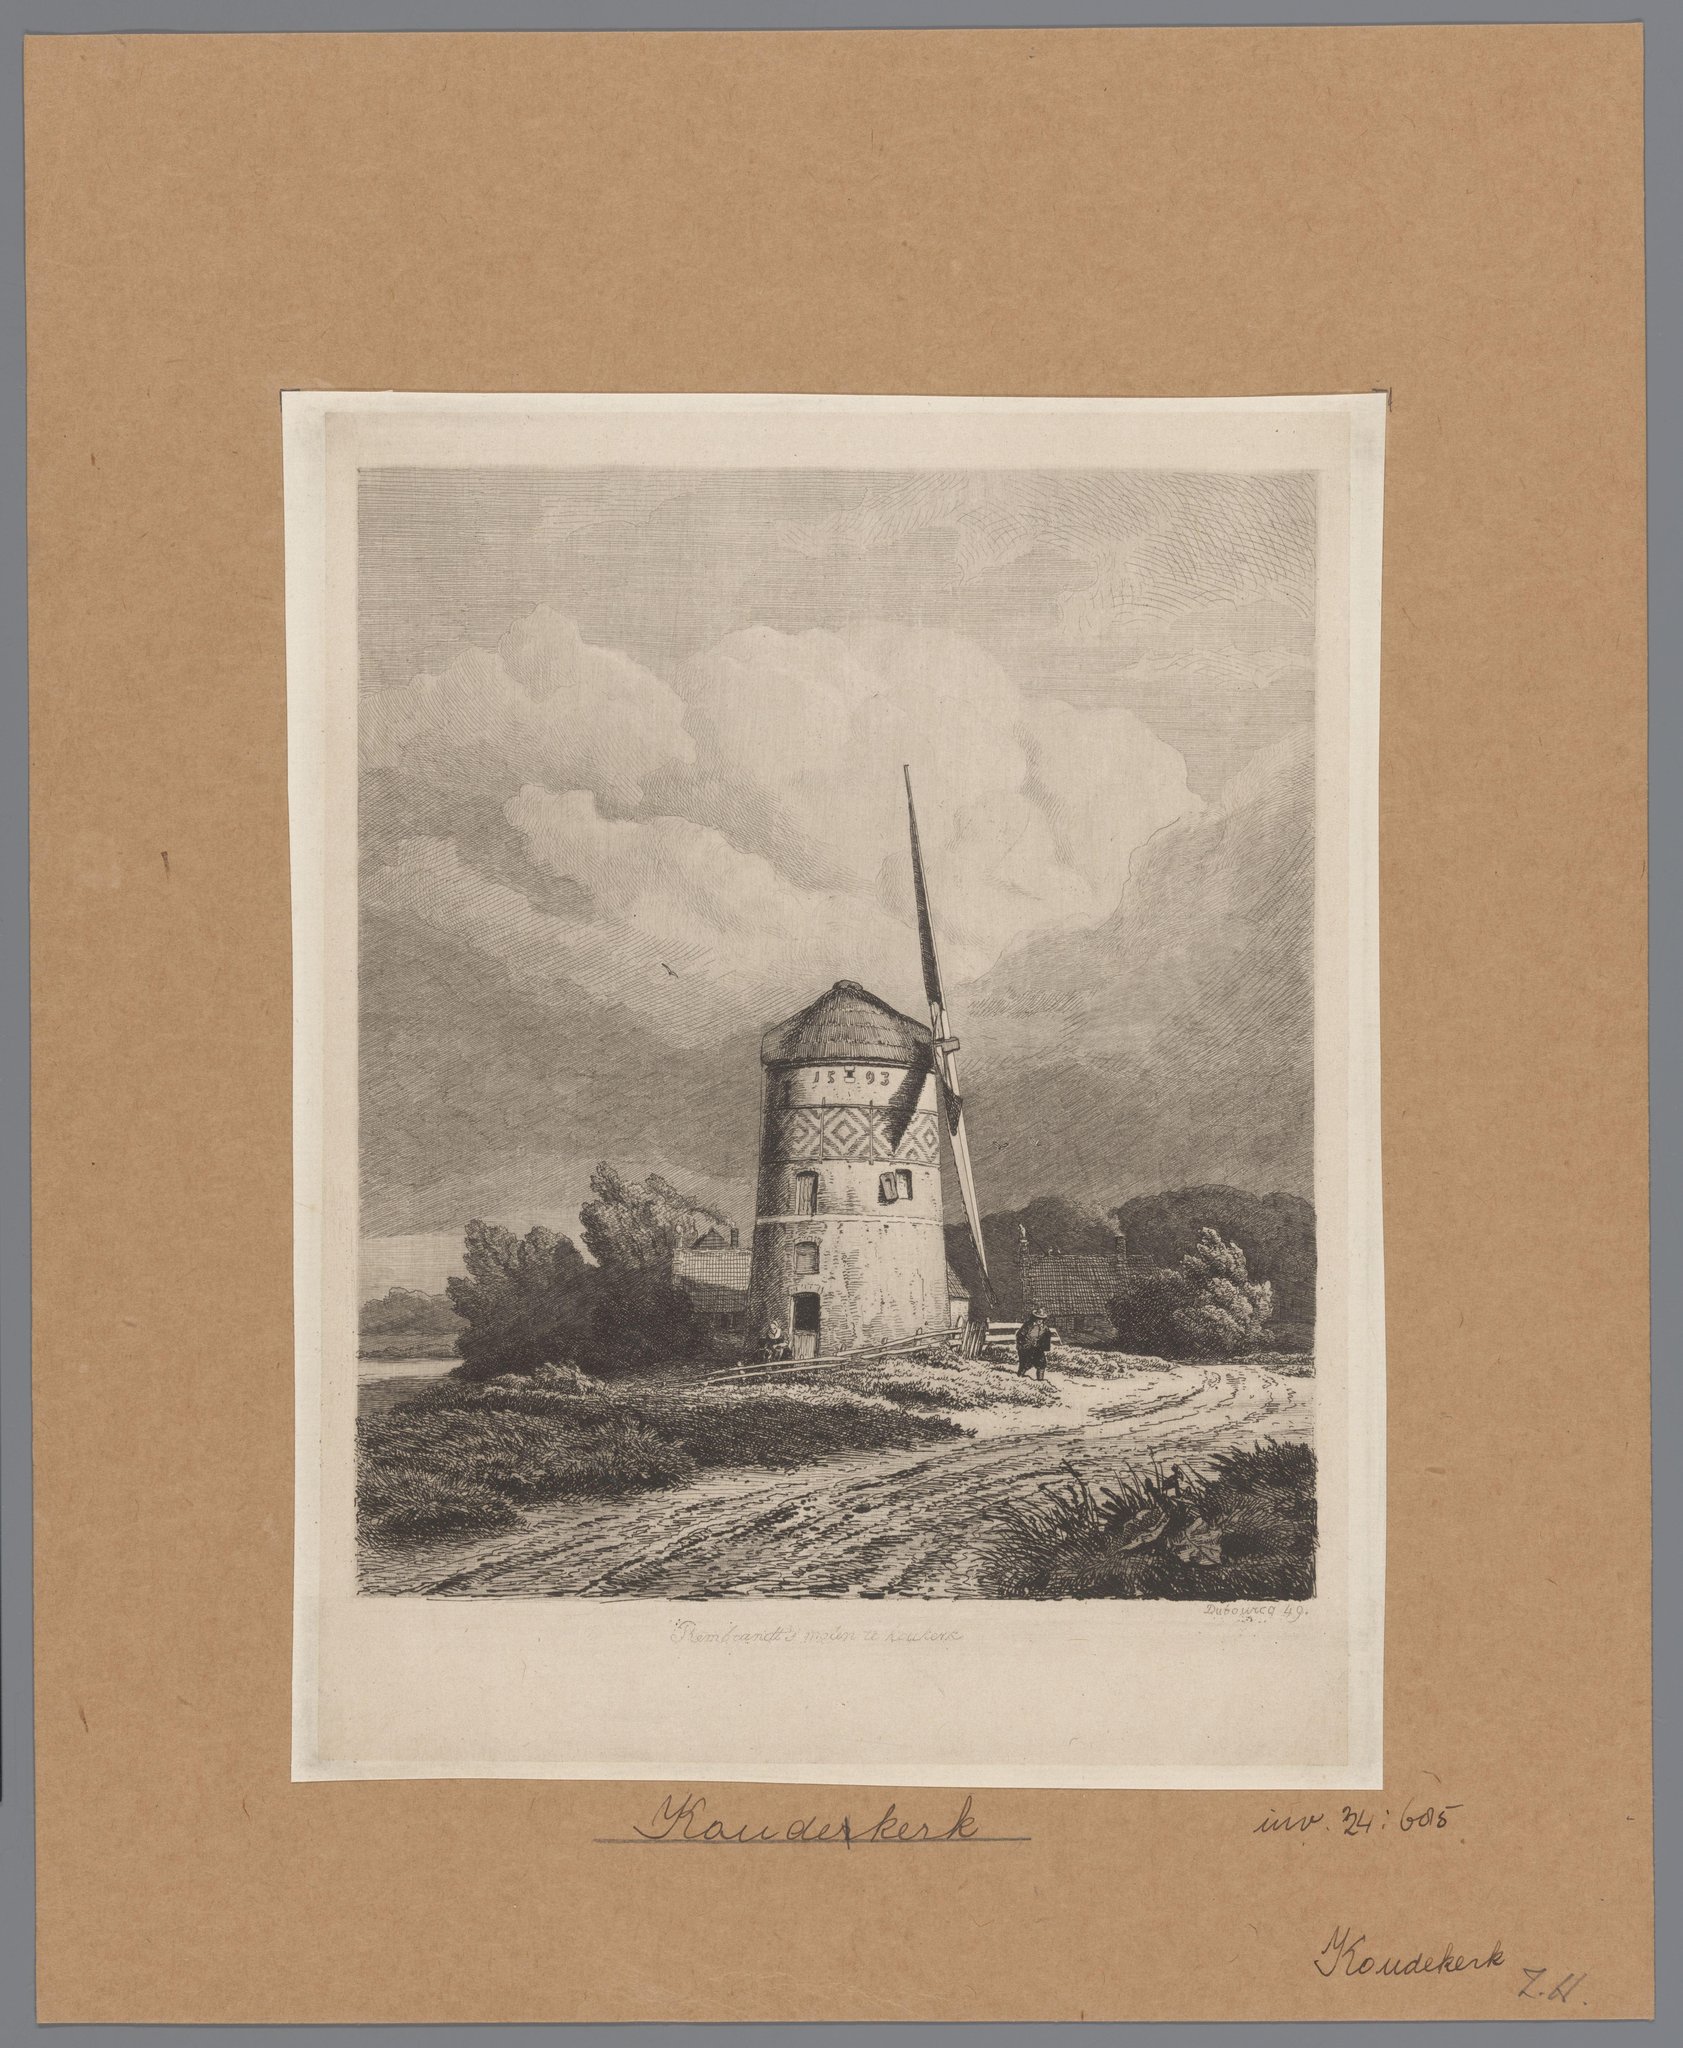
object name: print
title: Rembrandts molen te Koukerk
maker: pierre louis dubourcq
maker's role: draughtsman, painter, print maker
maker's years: 1815-1873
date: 1849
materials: paper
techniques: etching, intaglio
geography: netherlands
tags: windmill in landscape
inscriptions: collector's mark: Lugt 2228